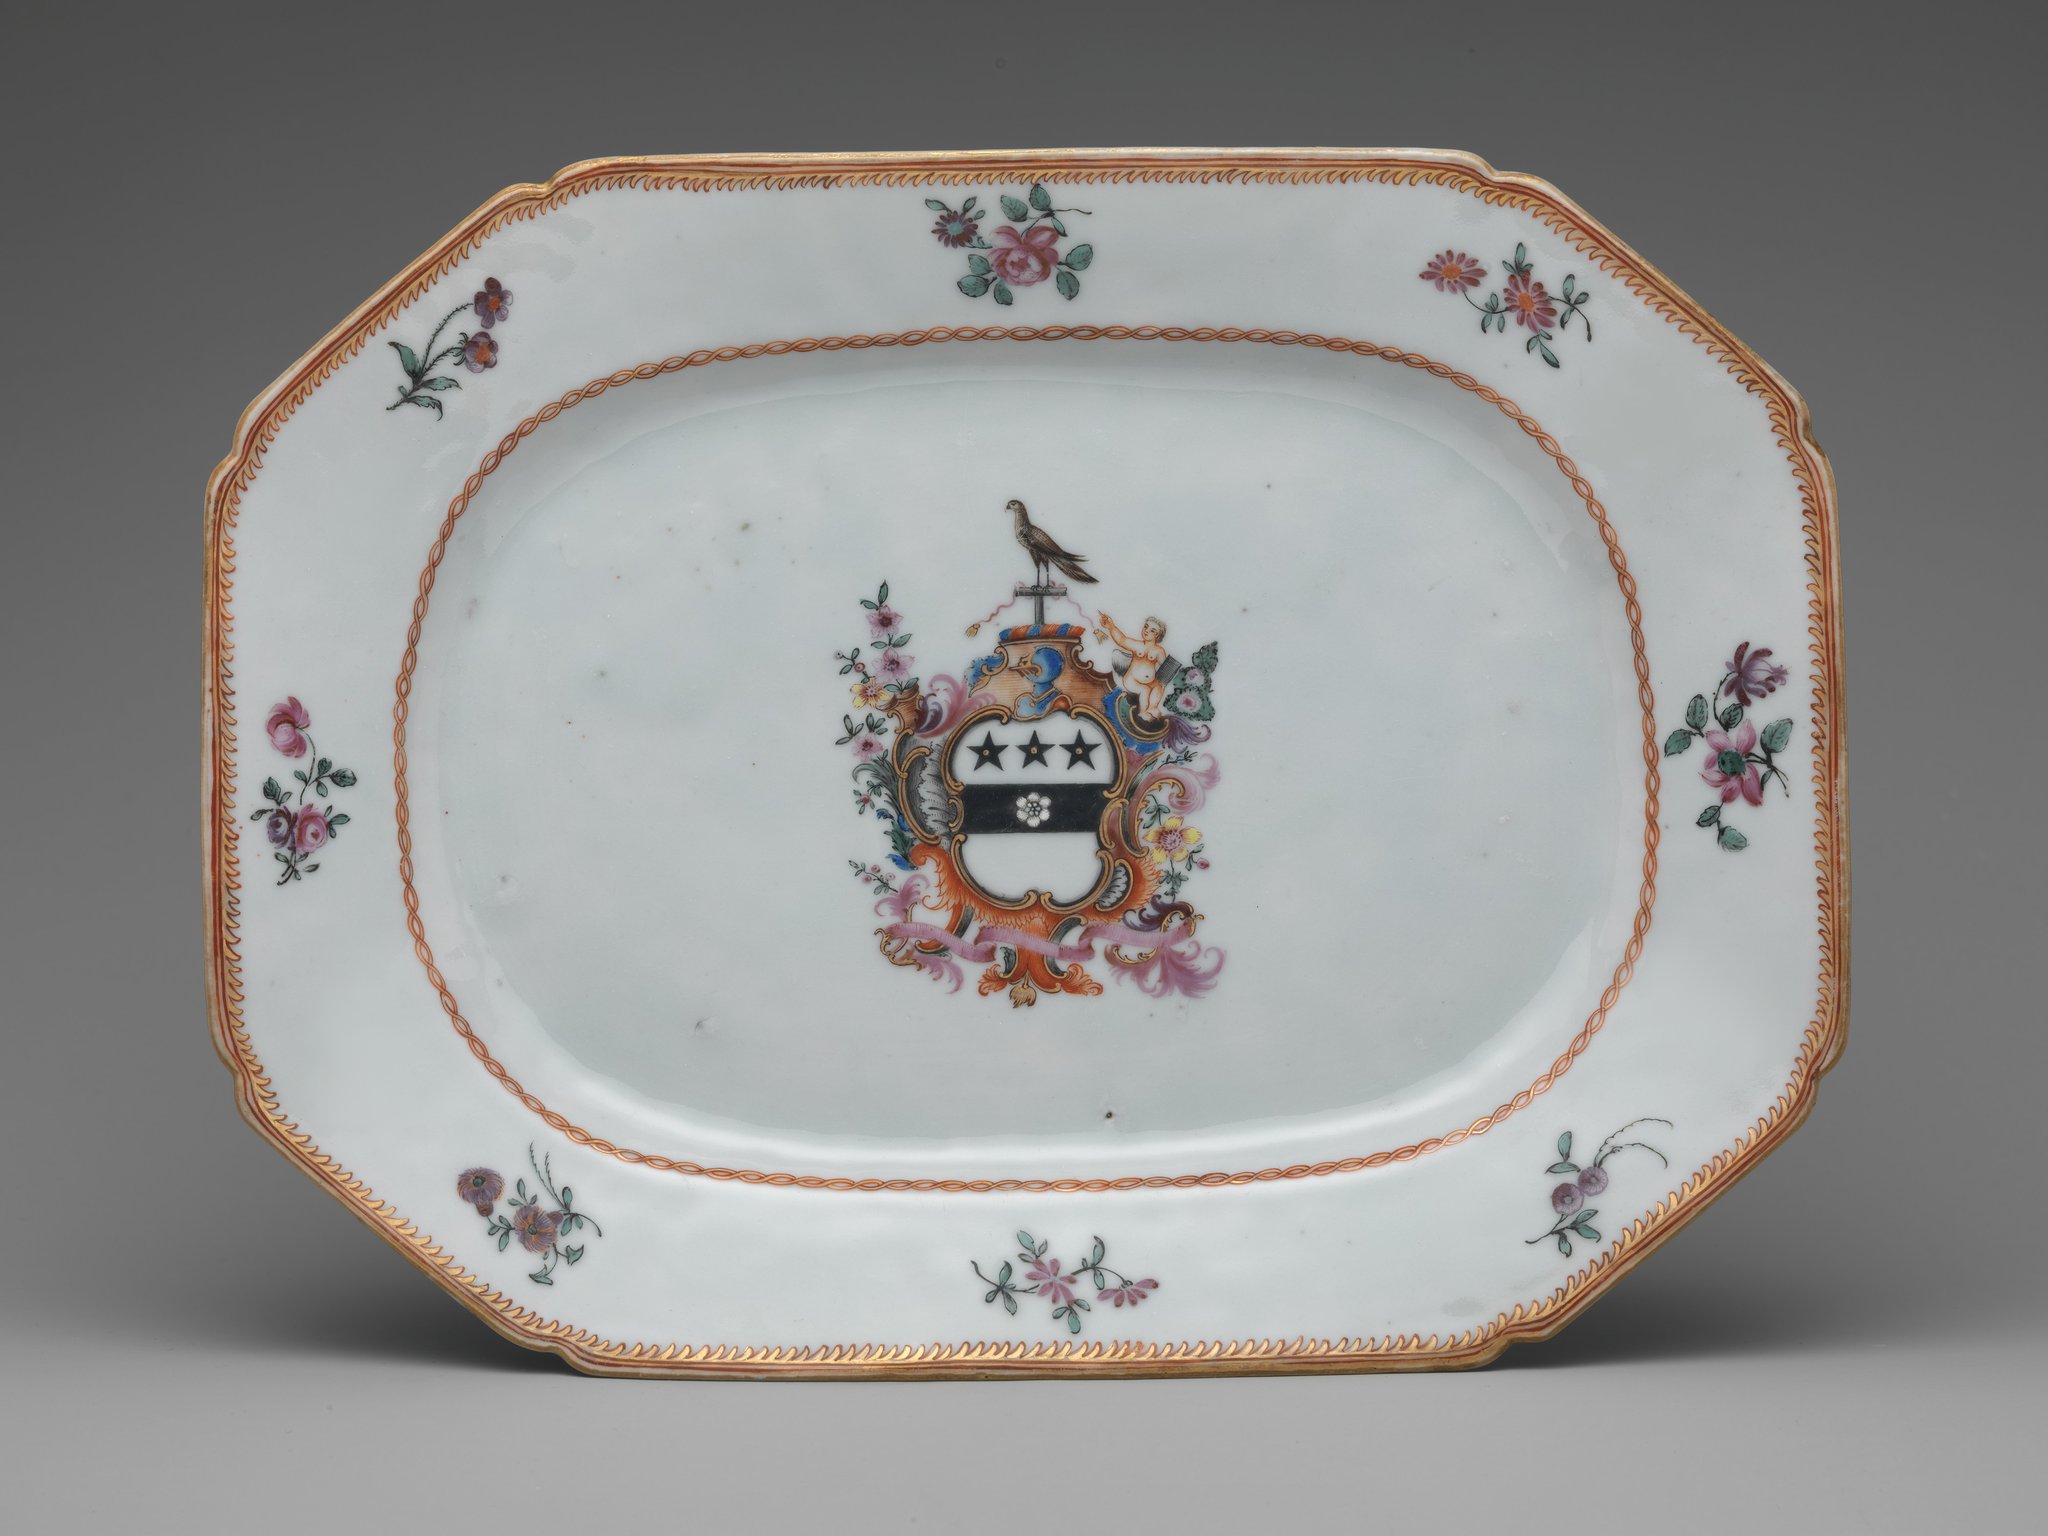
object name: platter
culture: chinese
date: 1785-1790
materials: porcelain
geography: china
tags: birds,coat of arms